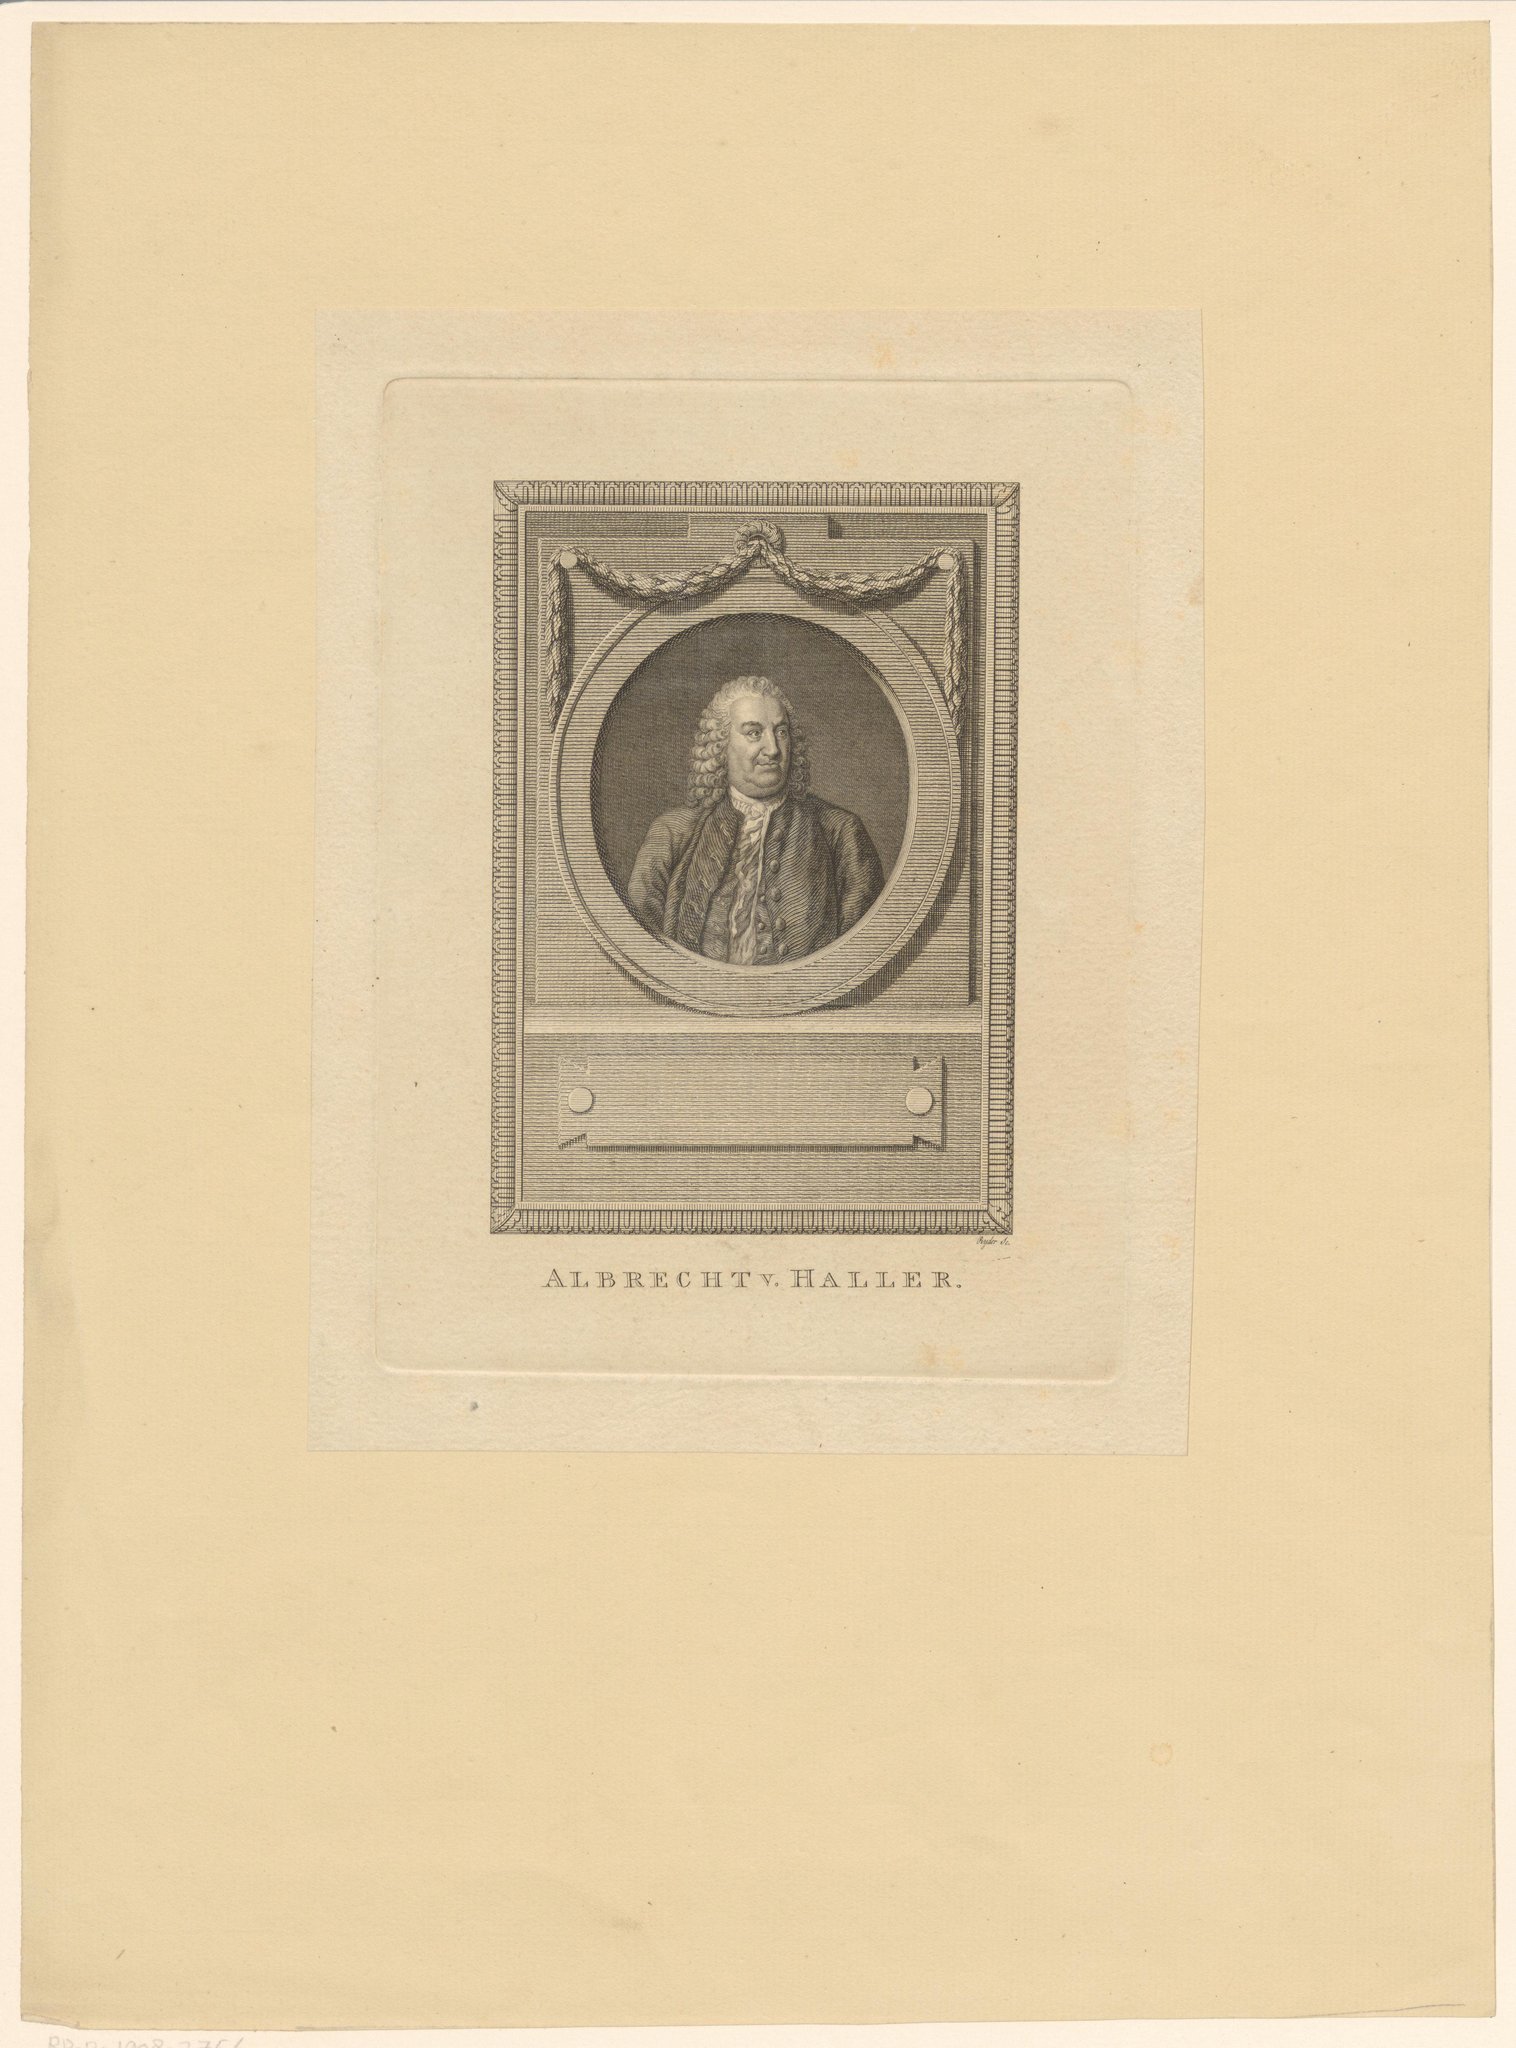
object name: print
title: Portret van Albrecht von Haller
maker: thomas ryder (i)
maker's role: print maker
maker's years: 1746-1810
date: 1756-1810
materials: paper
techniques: engraving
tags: physicist, botany (+ portrait of scholar, scientist), historical persons